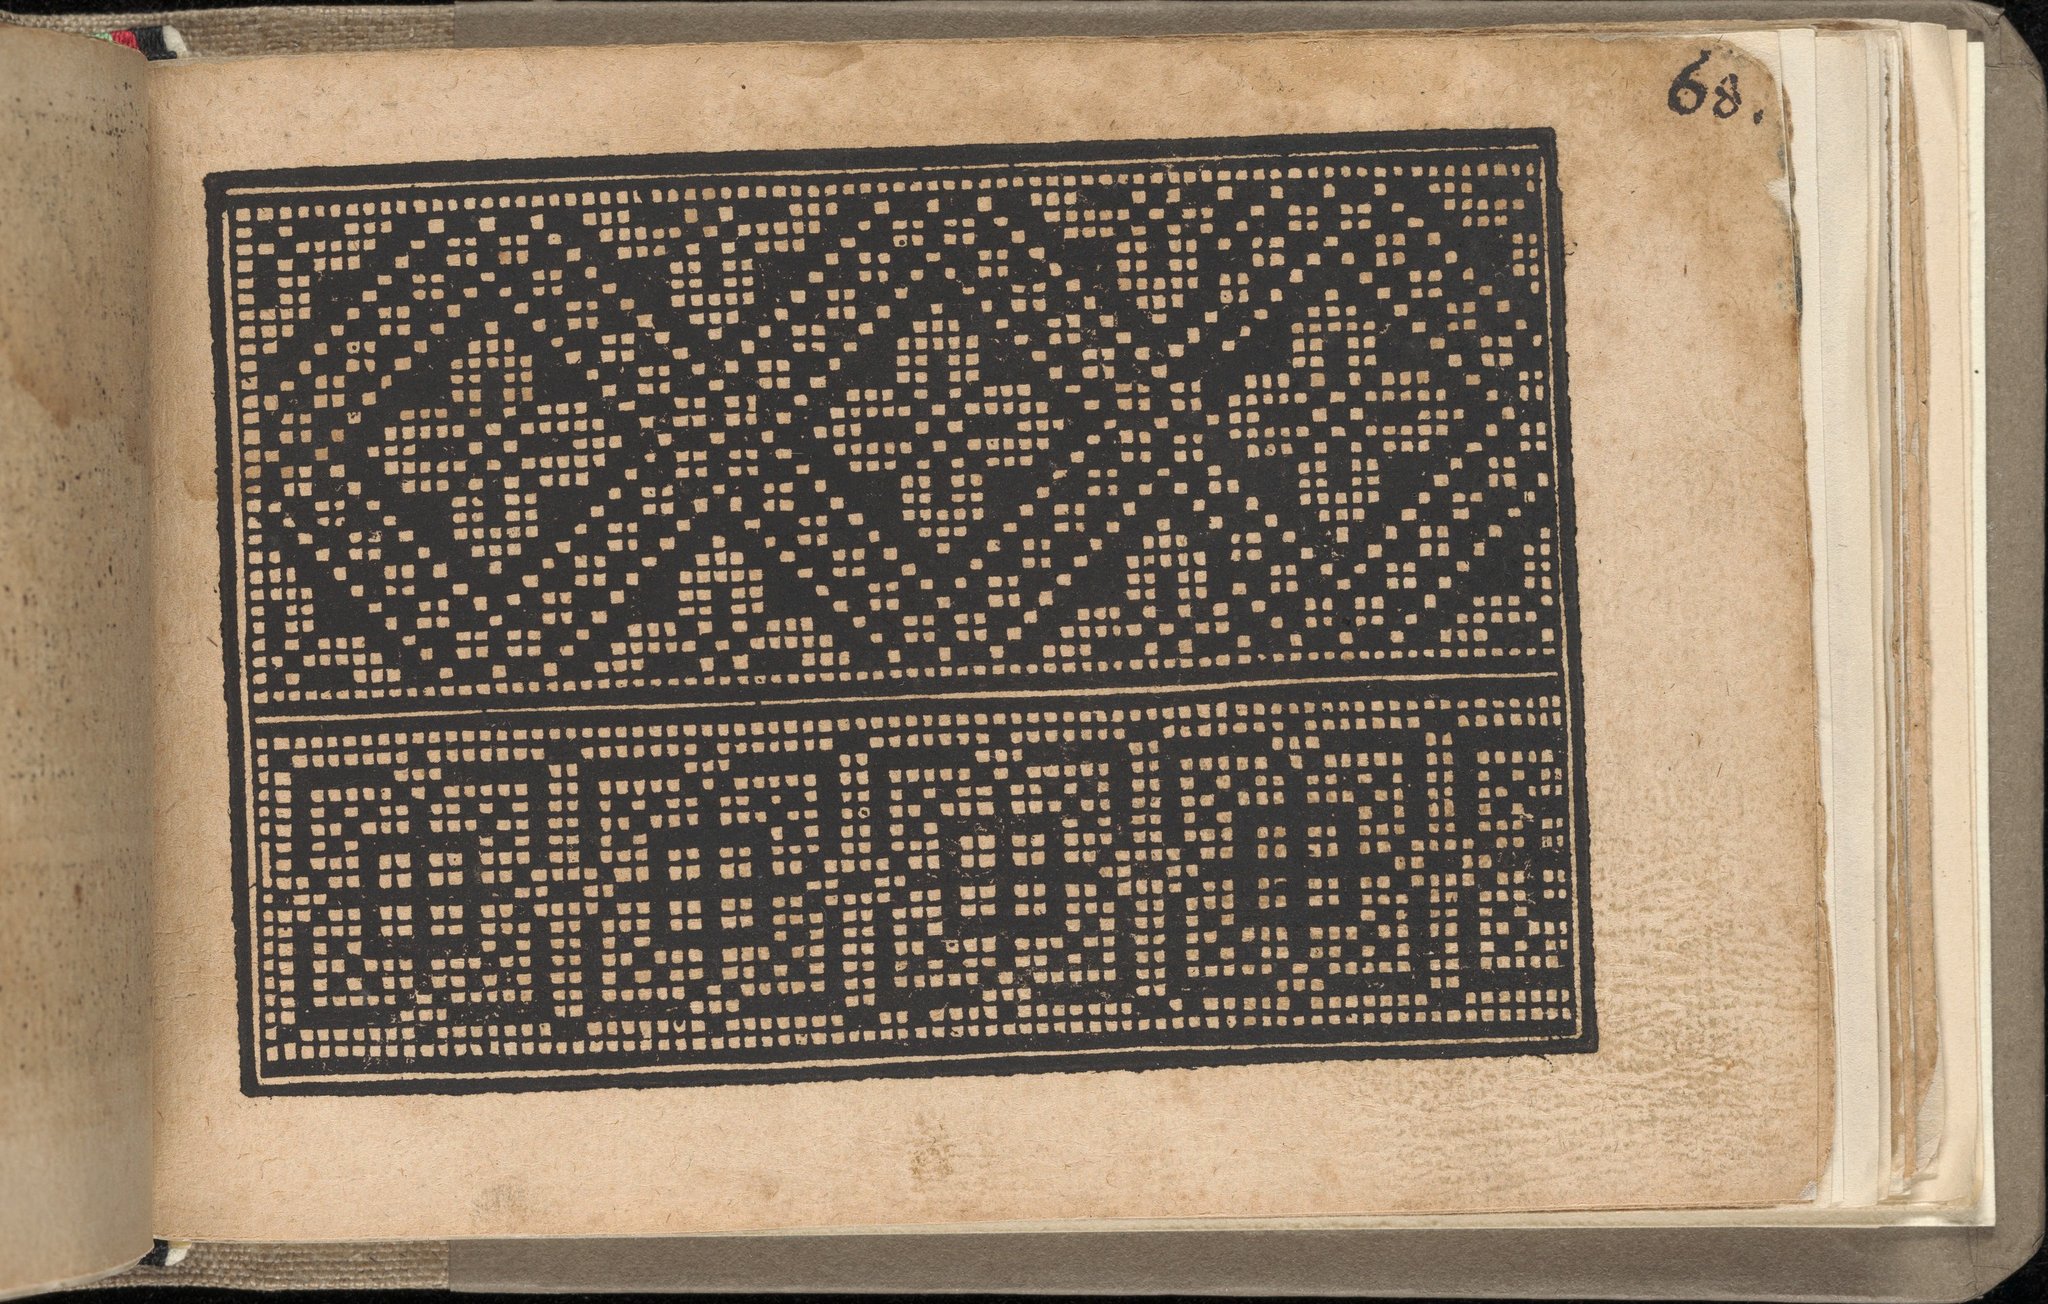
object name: book print ornament architecture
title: Schön newes Modelbuch (Page 68r)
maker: sigismundus latomus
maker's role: publisher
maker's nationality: german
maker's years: 1599-1632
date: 1608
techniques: woodcut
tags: ornament